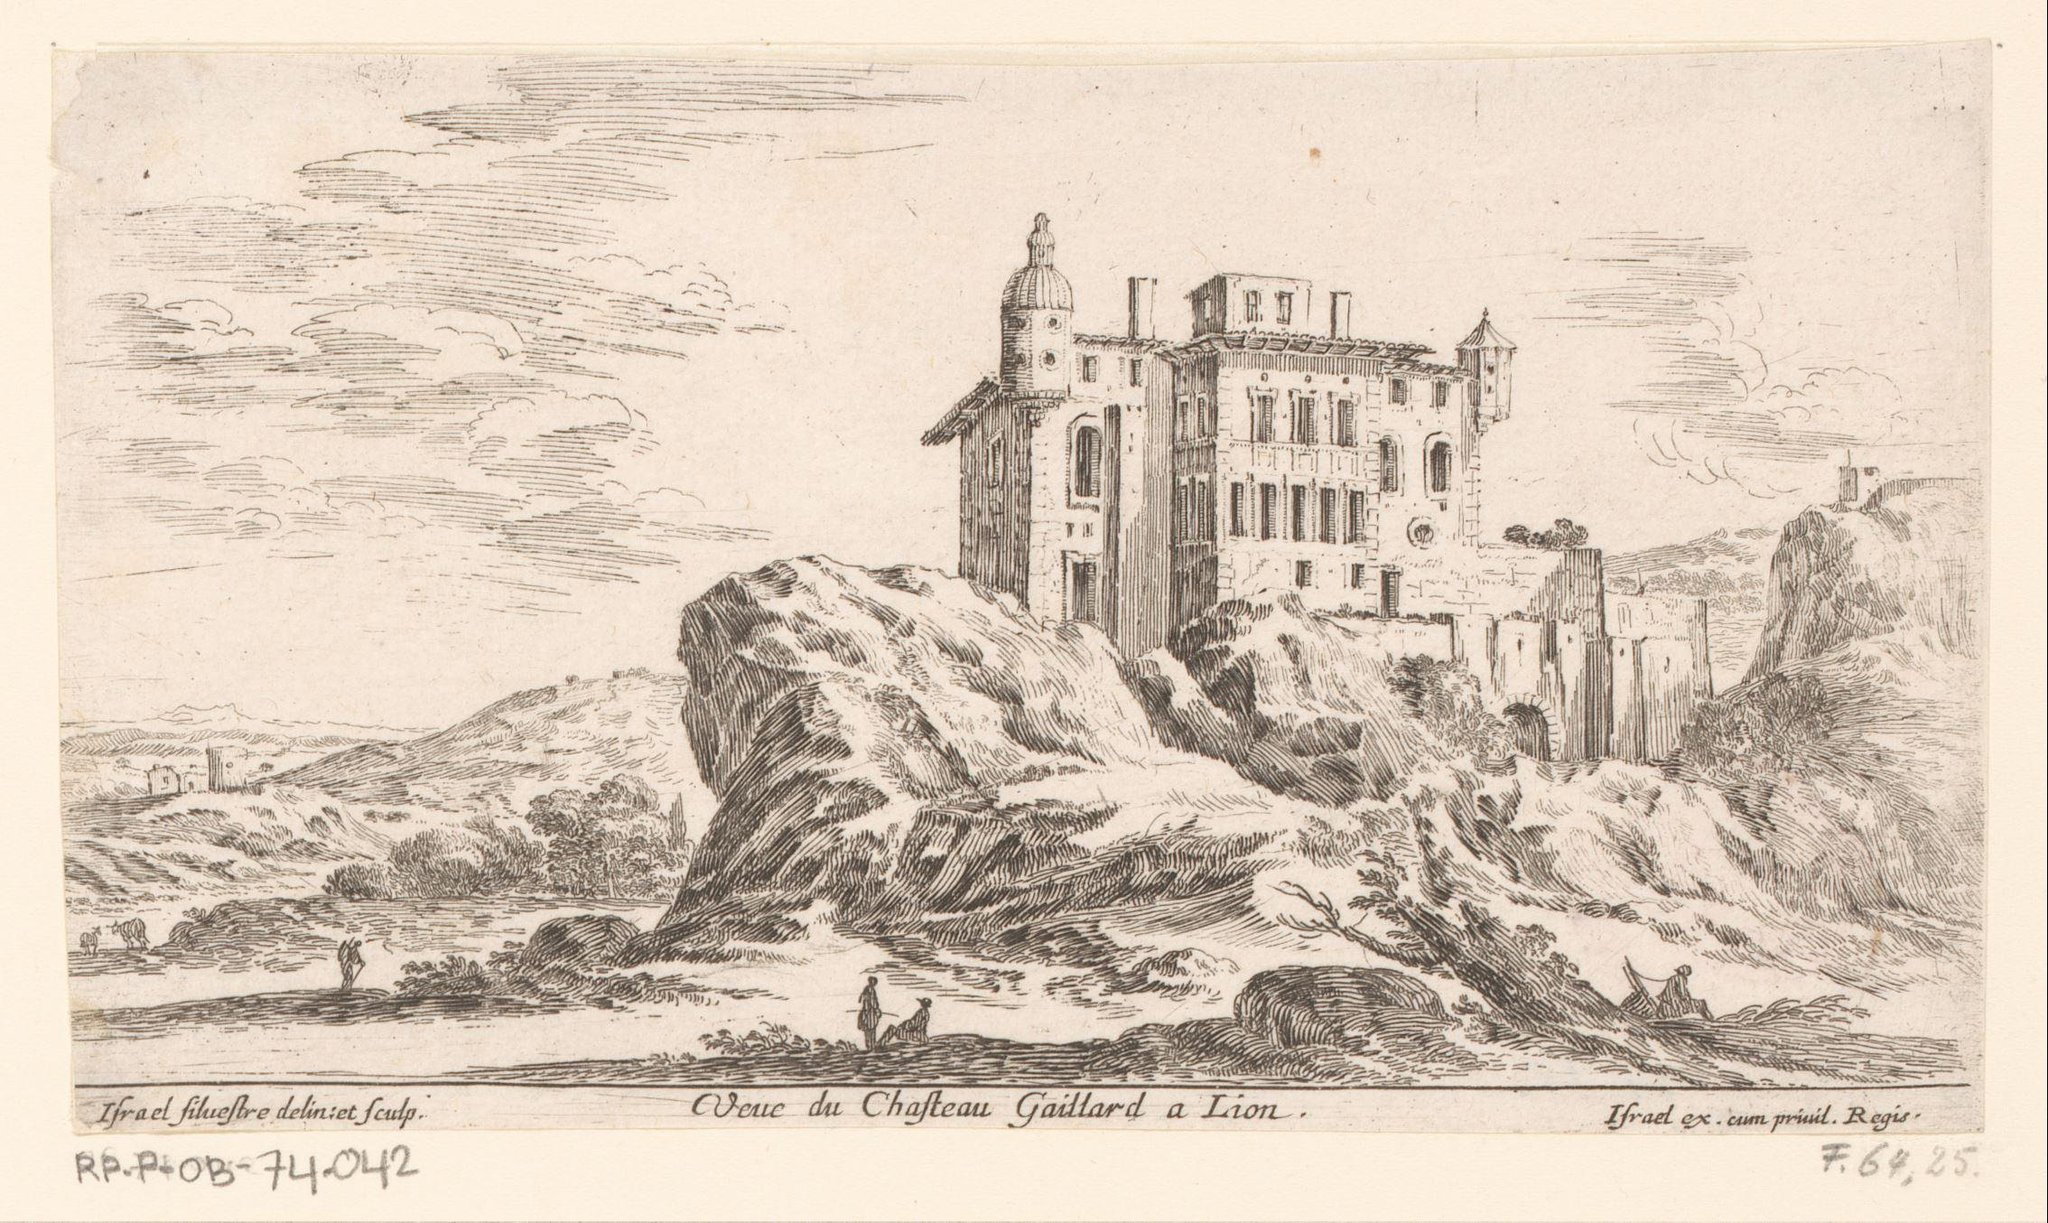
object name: print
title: Veue du Chasteau Gaillard a Lion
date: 1652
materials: paper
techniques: engraving, etching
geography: france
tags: landscape with tower or castle, lyon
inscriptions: collector's mark: Lugt 240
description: Prent maakt deel uit van een ongenummerde serie van 30 prenten.